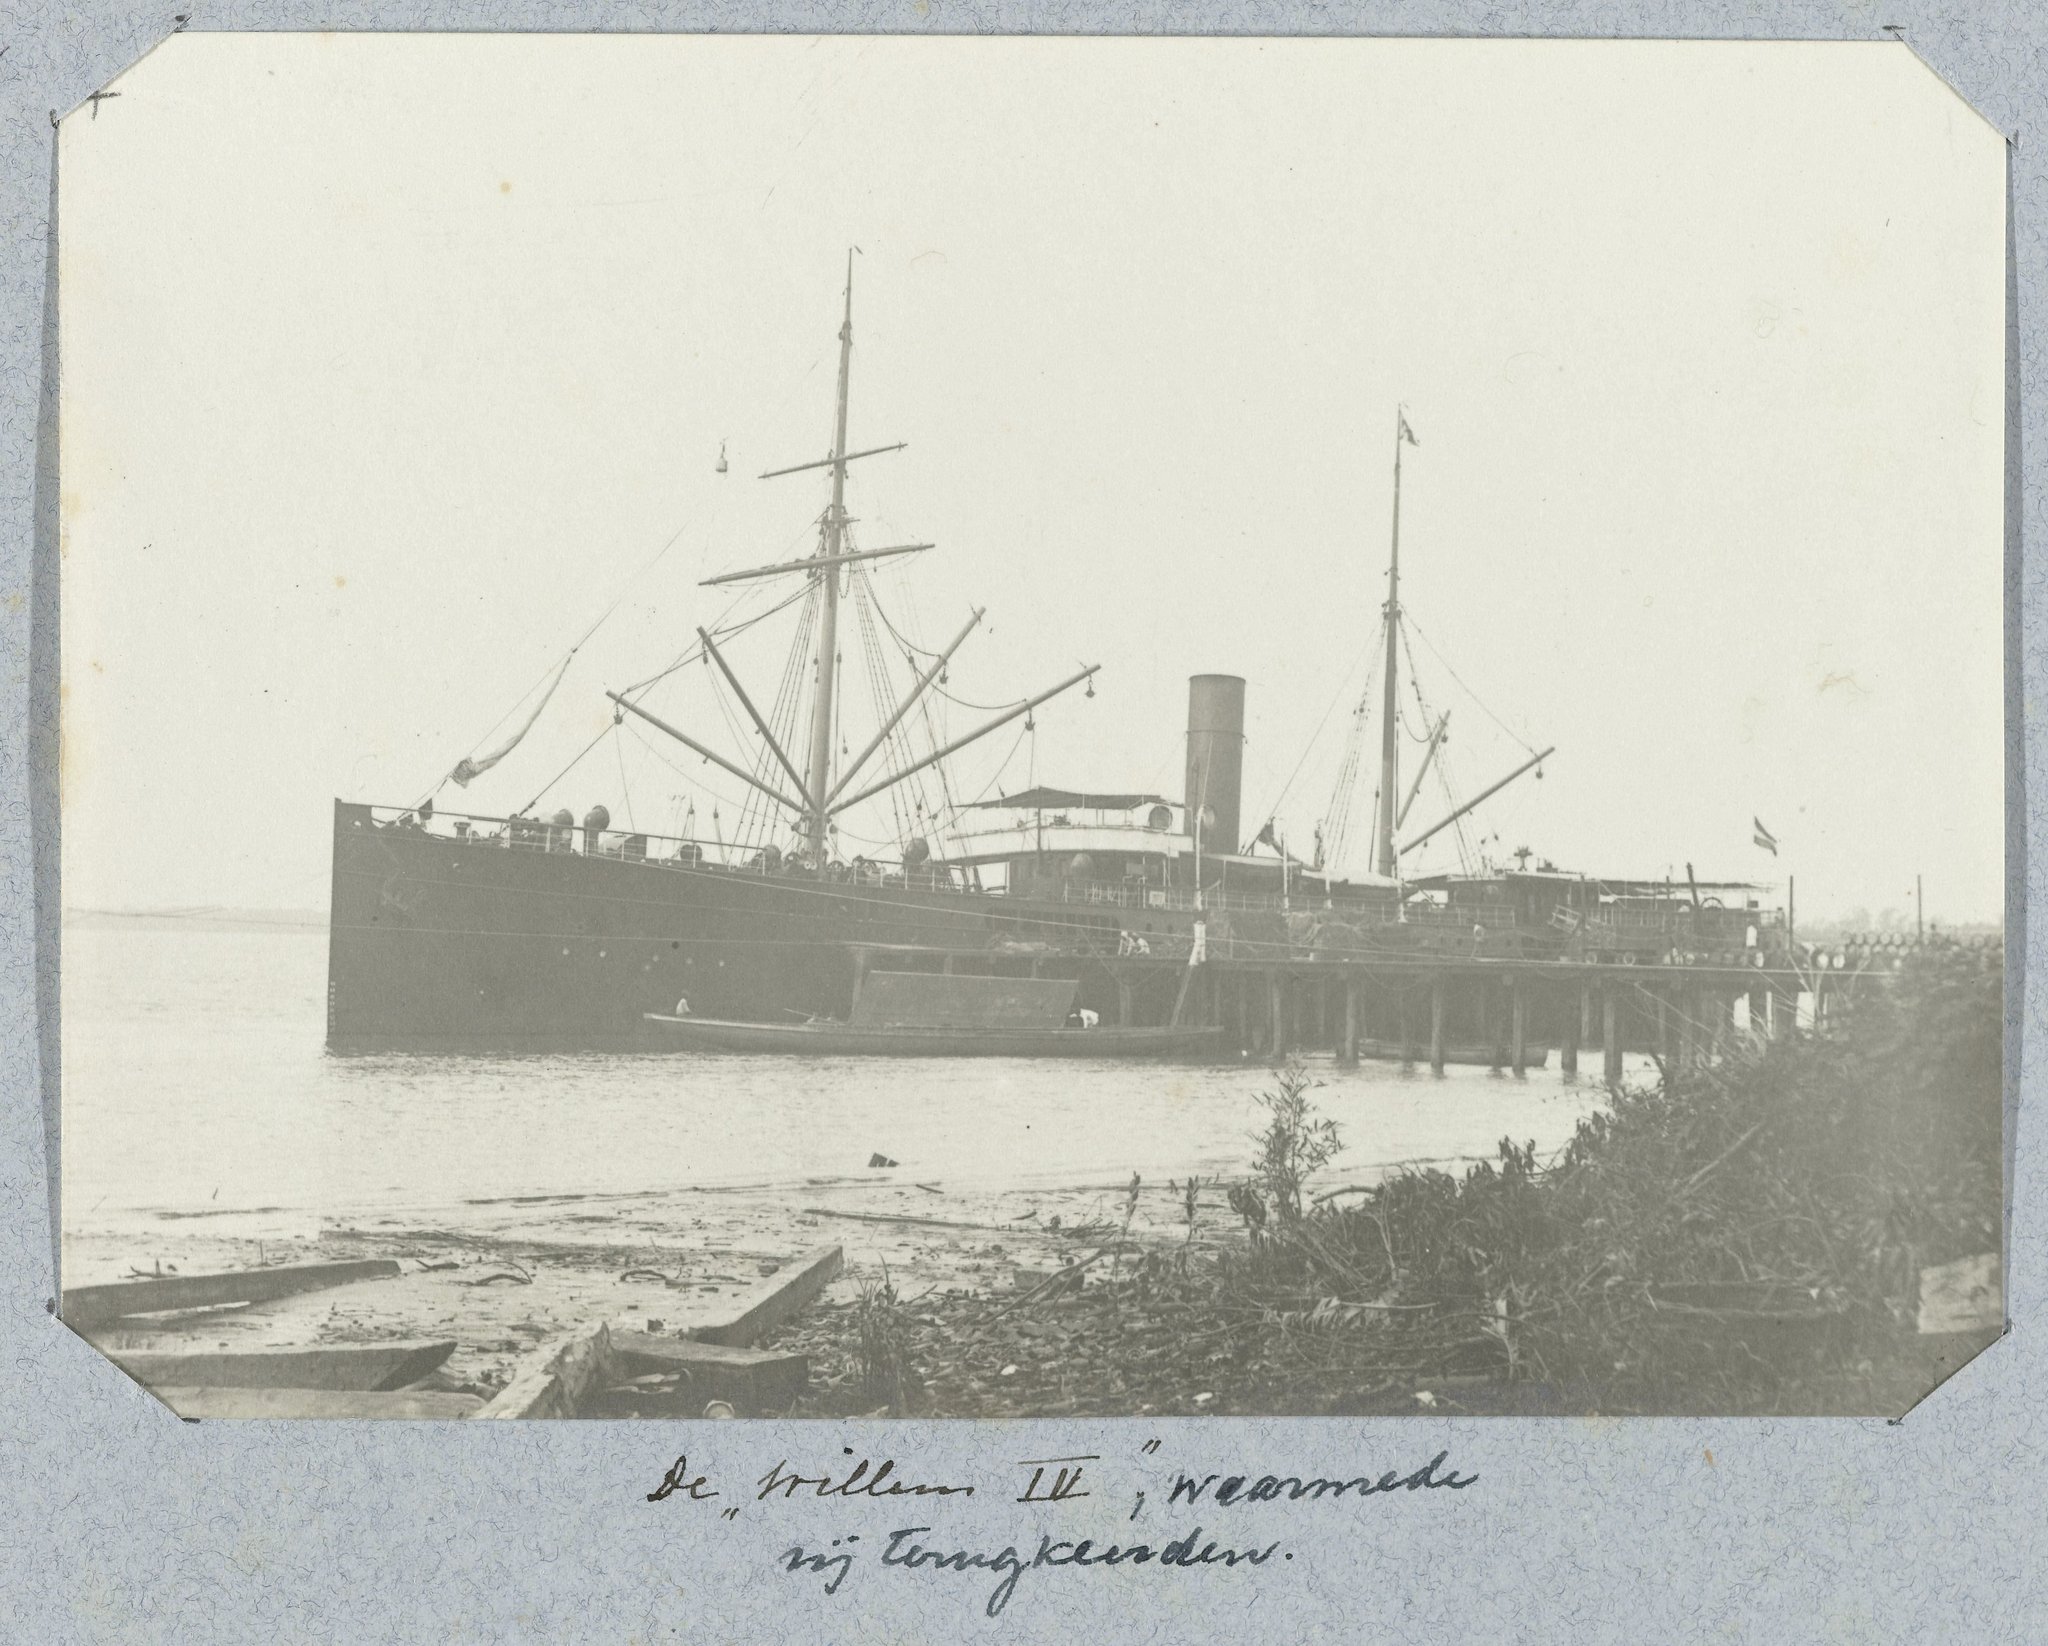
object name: photograph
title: De "Willem IV", waarmede wij terugkeerden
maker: théodore van lelyveld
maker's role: painter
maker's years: 1867-1954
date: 1898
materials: photographic support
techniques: gelatin silver print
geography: suriname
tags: sailing-ship, sailing-boat, steamship, motorship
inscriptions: inscription: ‘De "Willem IV", waarmede wij terugkeerden.’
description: Het schip genaamd Willem IV, liggend aan een steiger te Paramaribo. Het schip waarmee de familie Van Lelyveld naar Nederland terugkeerde. Fotoafdruk in een fotoalbum van Théodore van Lelyveld over Suriname uit 1895-1898.